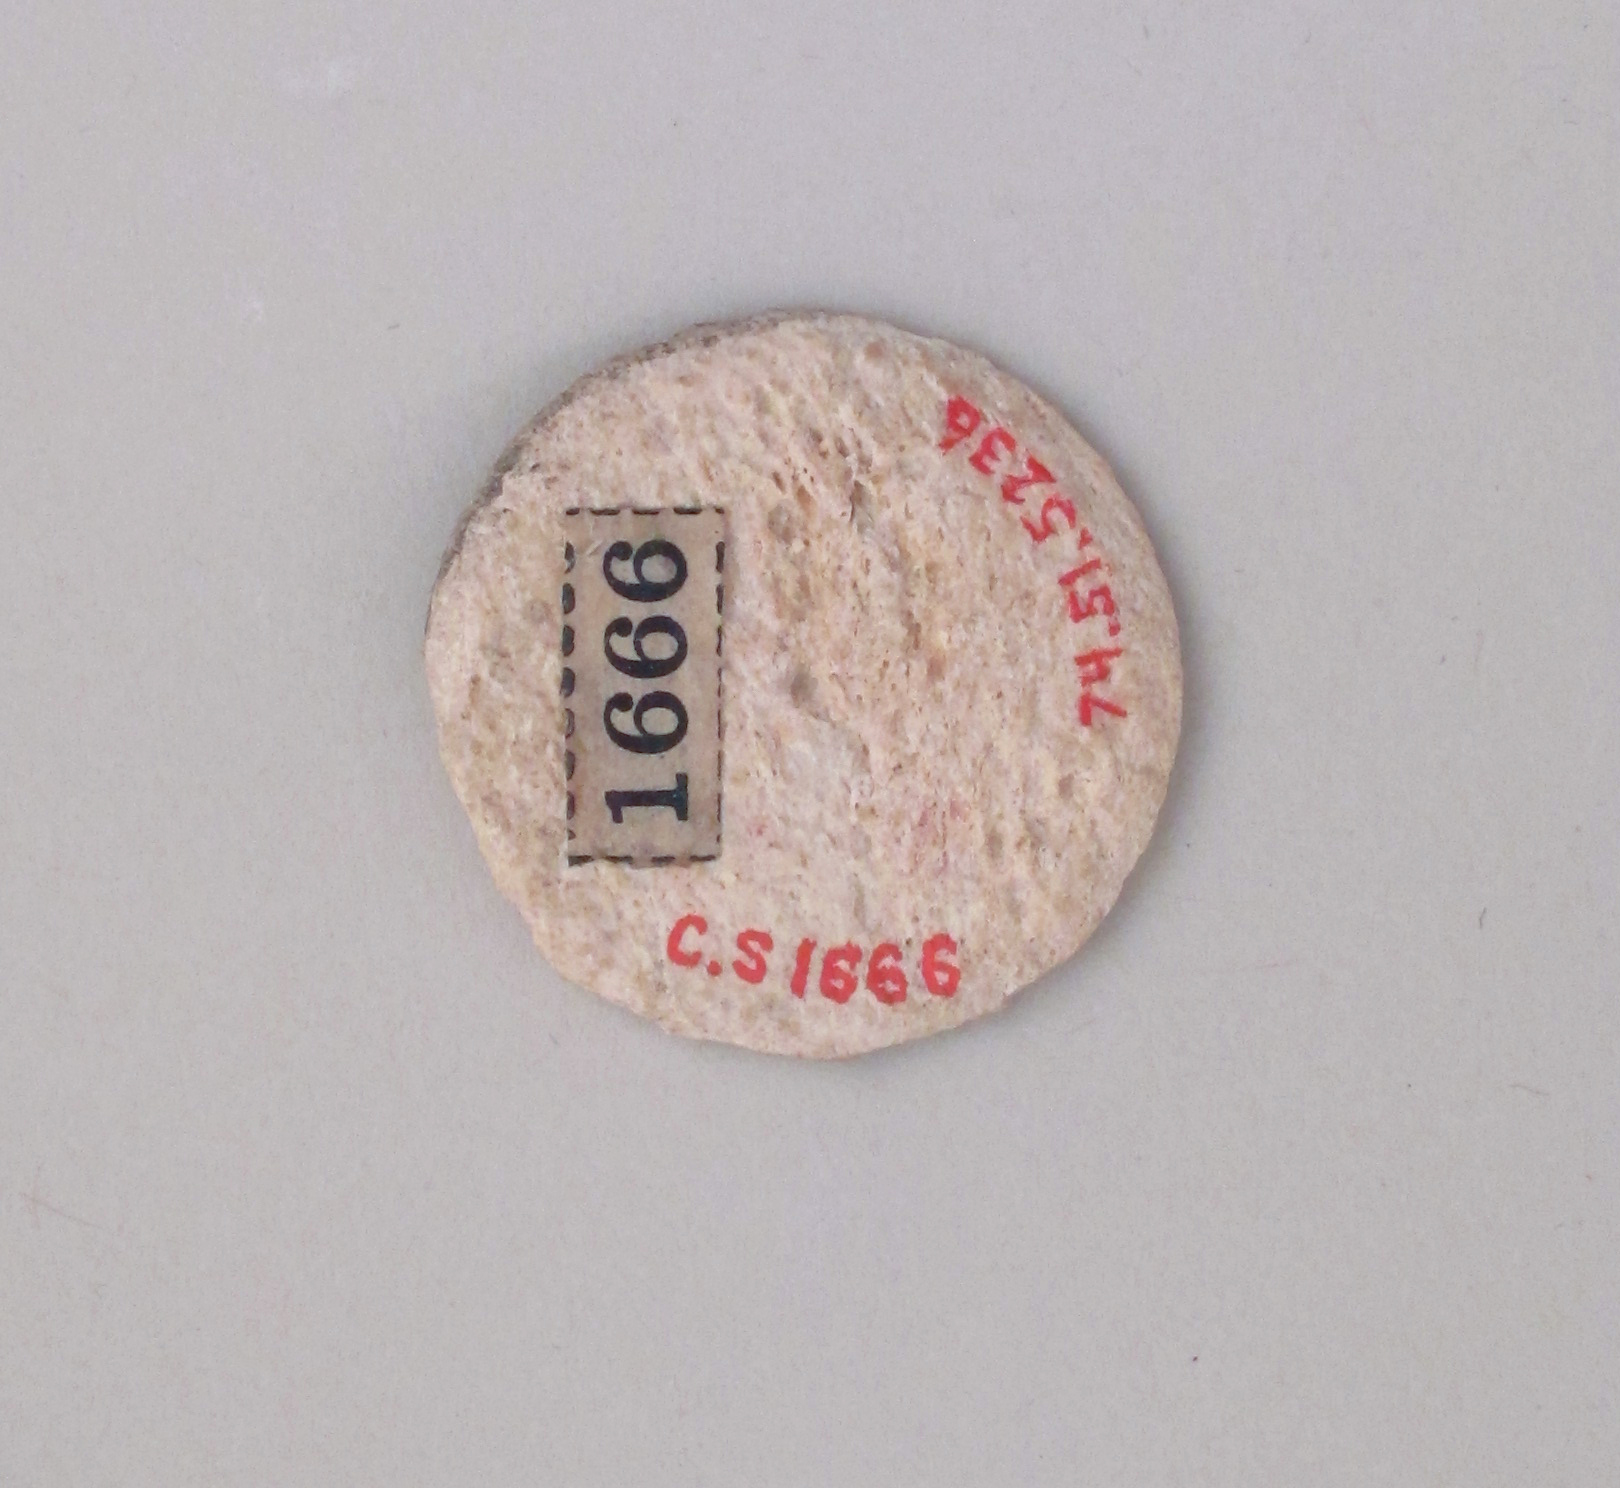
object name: roundel, disk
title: Ivory disk of a pyxis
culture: cypriot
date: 1300-1101 BCE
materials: ivory